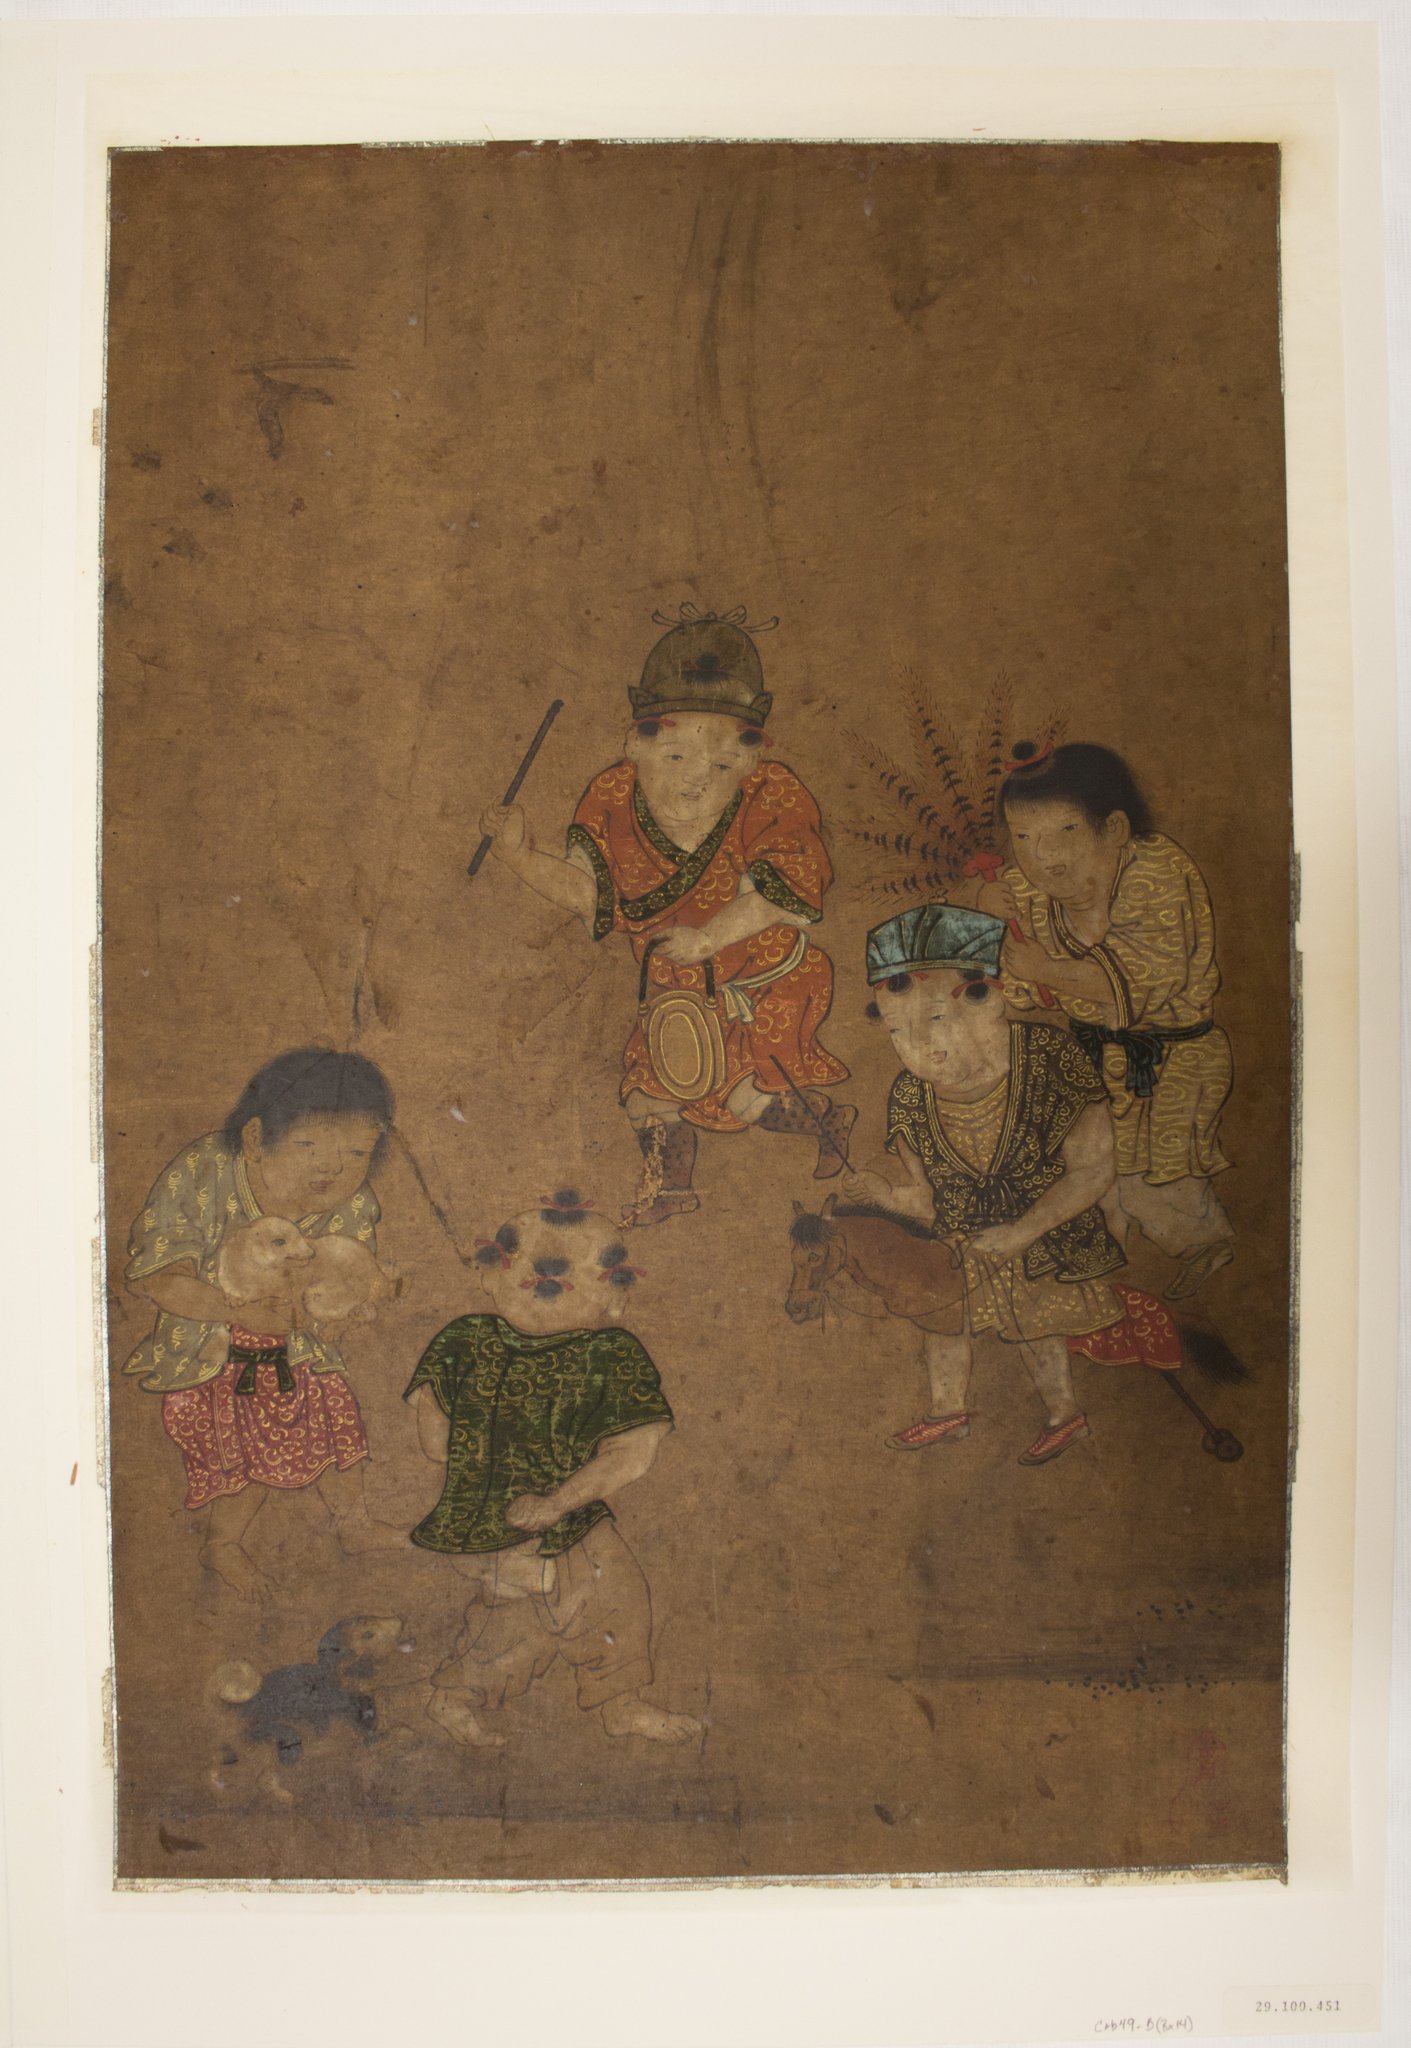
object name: painting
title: Chinese Children at Play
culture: japanese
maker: isei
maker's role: artist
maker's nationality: japanese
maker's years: 1536-1570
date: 1534-1573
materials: ink, paper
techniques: painting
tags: children,playing,dogs